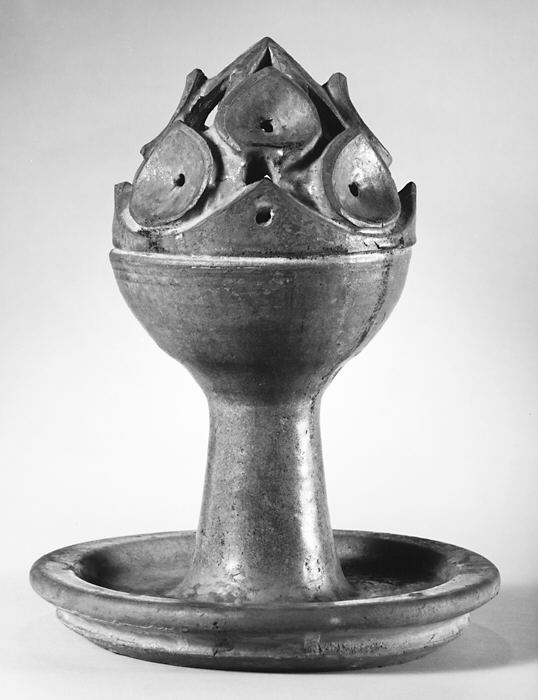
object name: incense burner with cover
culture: chinese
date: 206 BCE-220 CE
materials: earthenware, glaze